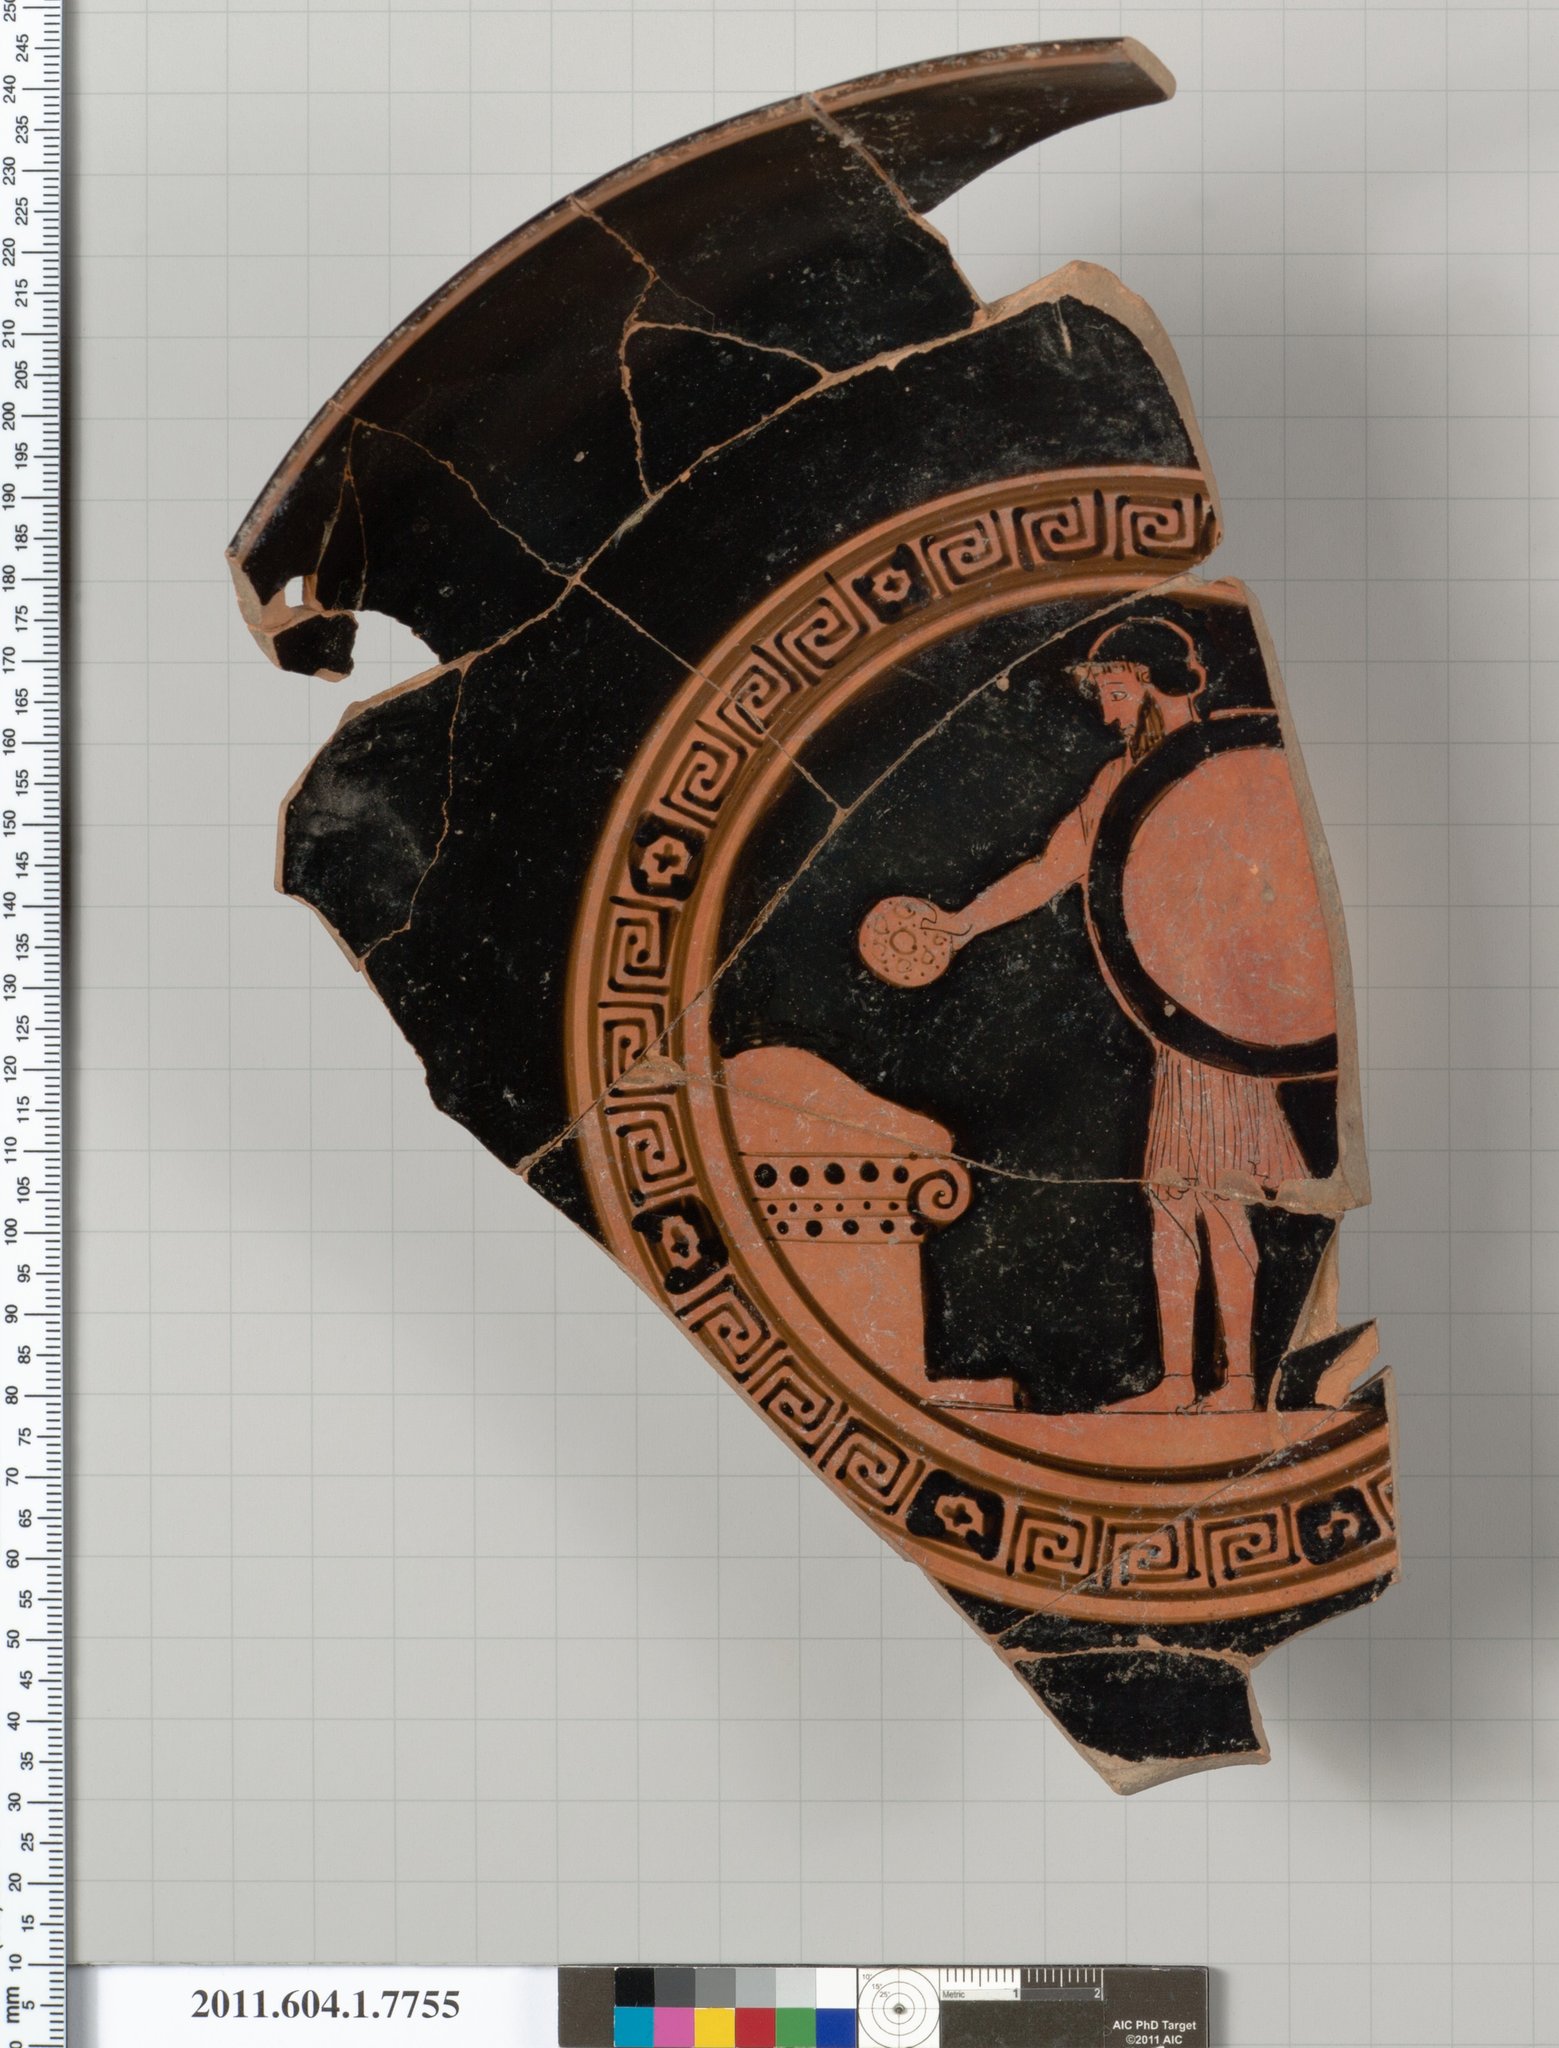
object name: kylix fragment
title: Terracotta fragment of a kylix (drinking cup)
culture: greek, attic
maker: lyandros painter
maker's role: artist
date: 470-460 BCE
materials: terracotta